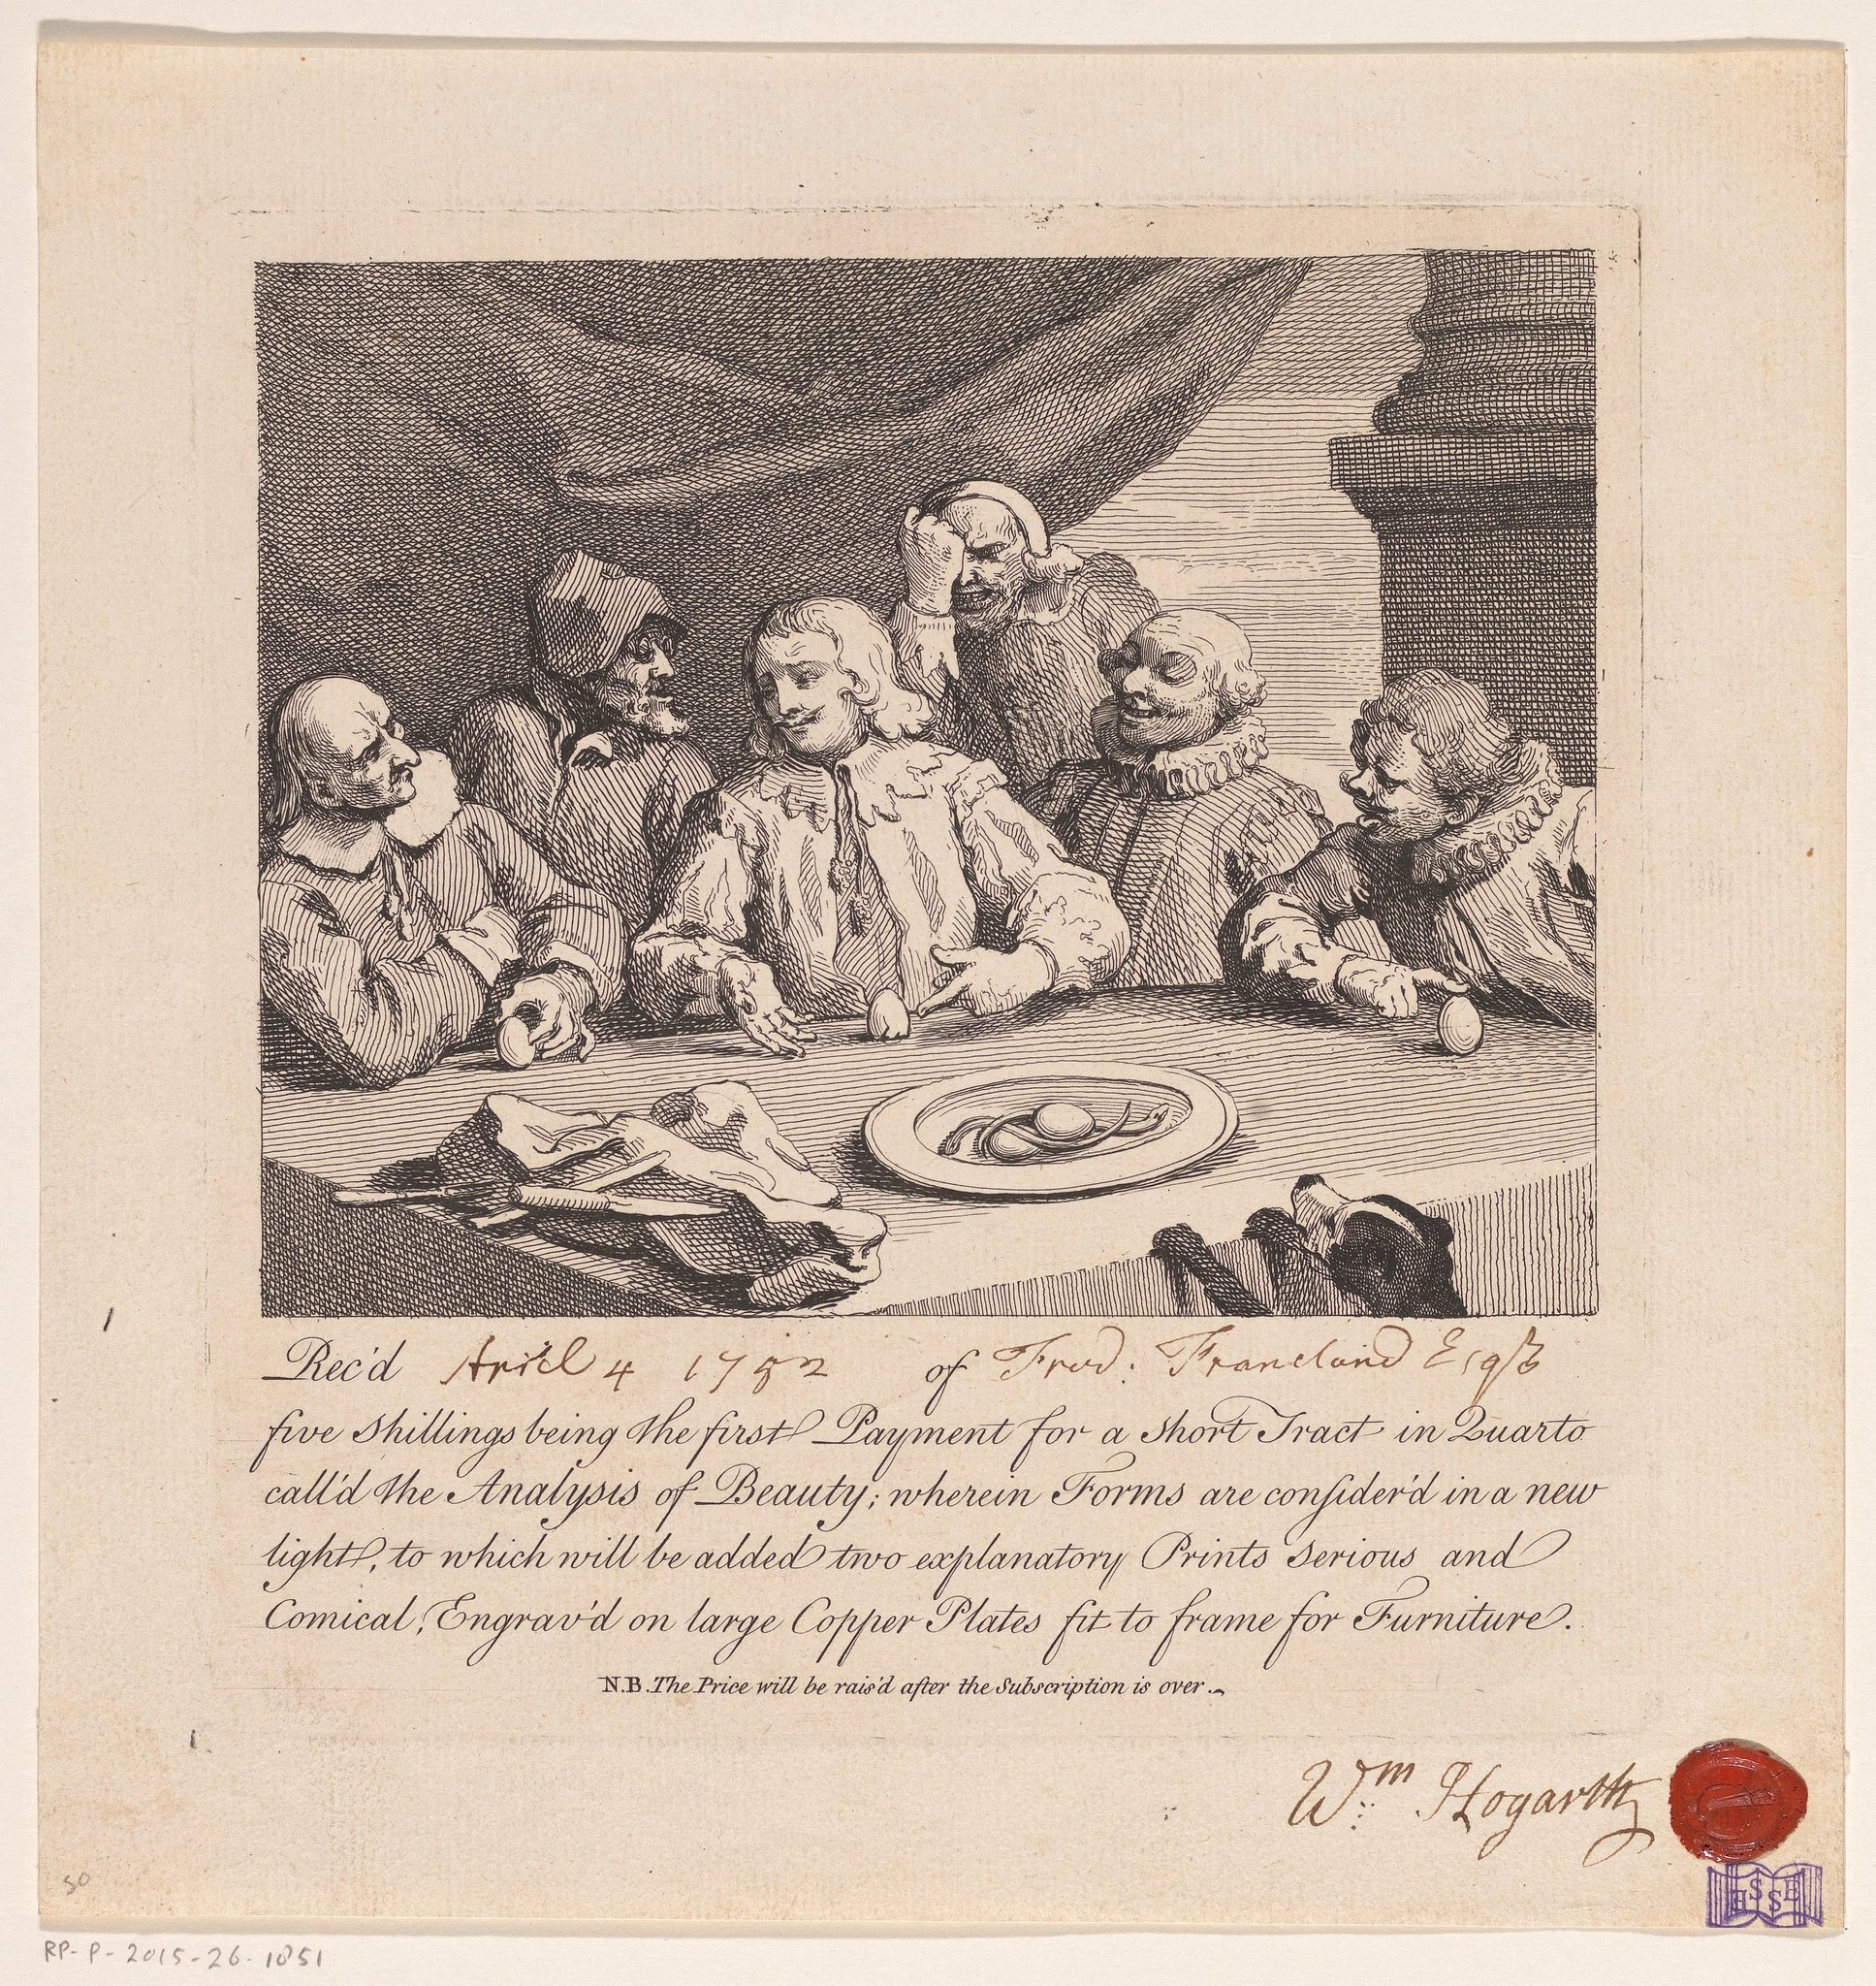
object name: ontvangstbewijs, kwitantie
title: Ontvangstbewijs voor een aanbetaling voor The Analysis of Beauty door William Hogarth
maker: william hogarth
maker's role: draughtsman, painter, print maker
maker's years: 1697-1764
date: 1752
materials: ink, paper, wax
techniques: printing, etching, pen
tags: eggs, egg-dishes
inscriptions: annotation: ‘April 4 1752 / Fred. Francland Esqr. / Wm. Hogarth’, seal: ‘schilderspalet’, collector's mark: Lugt 2228, collector's mark: Lugt 4779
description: Waarschijnlijk was dit ontvangstbewijs bedoeld voor Frederick Frankland (ca. 1694-1768).